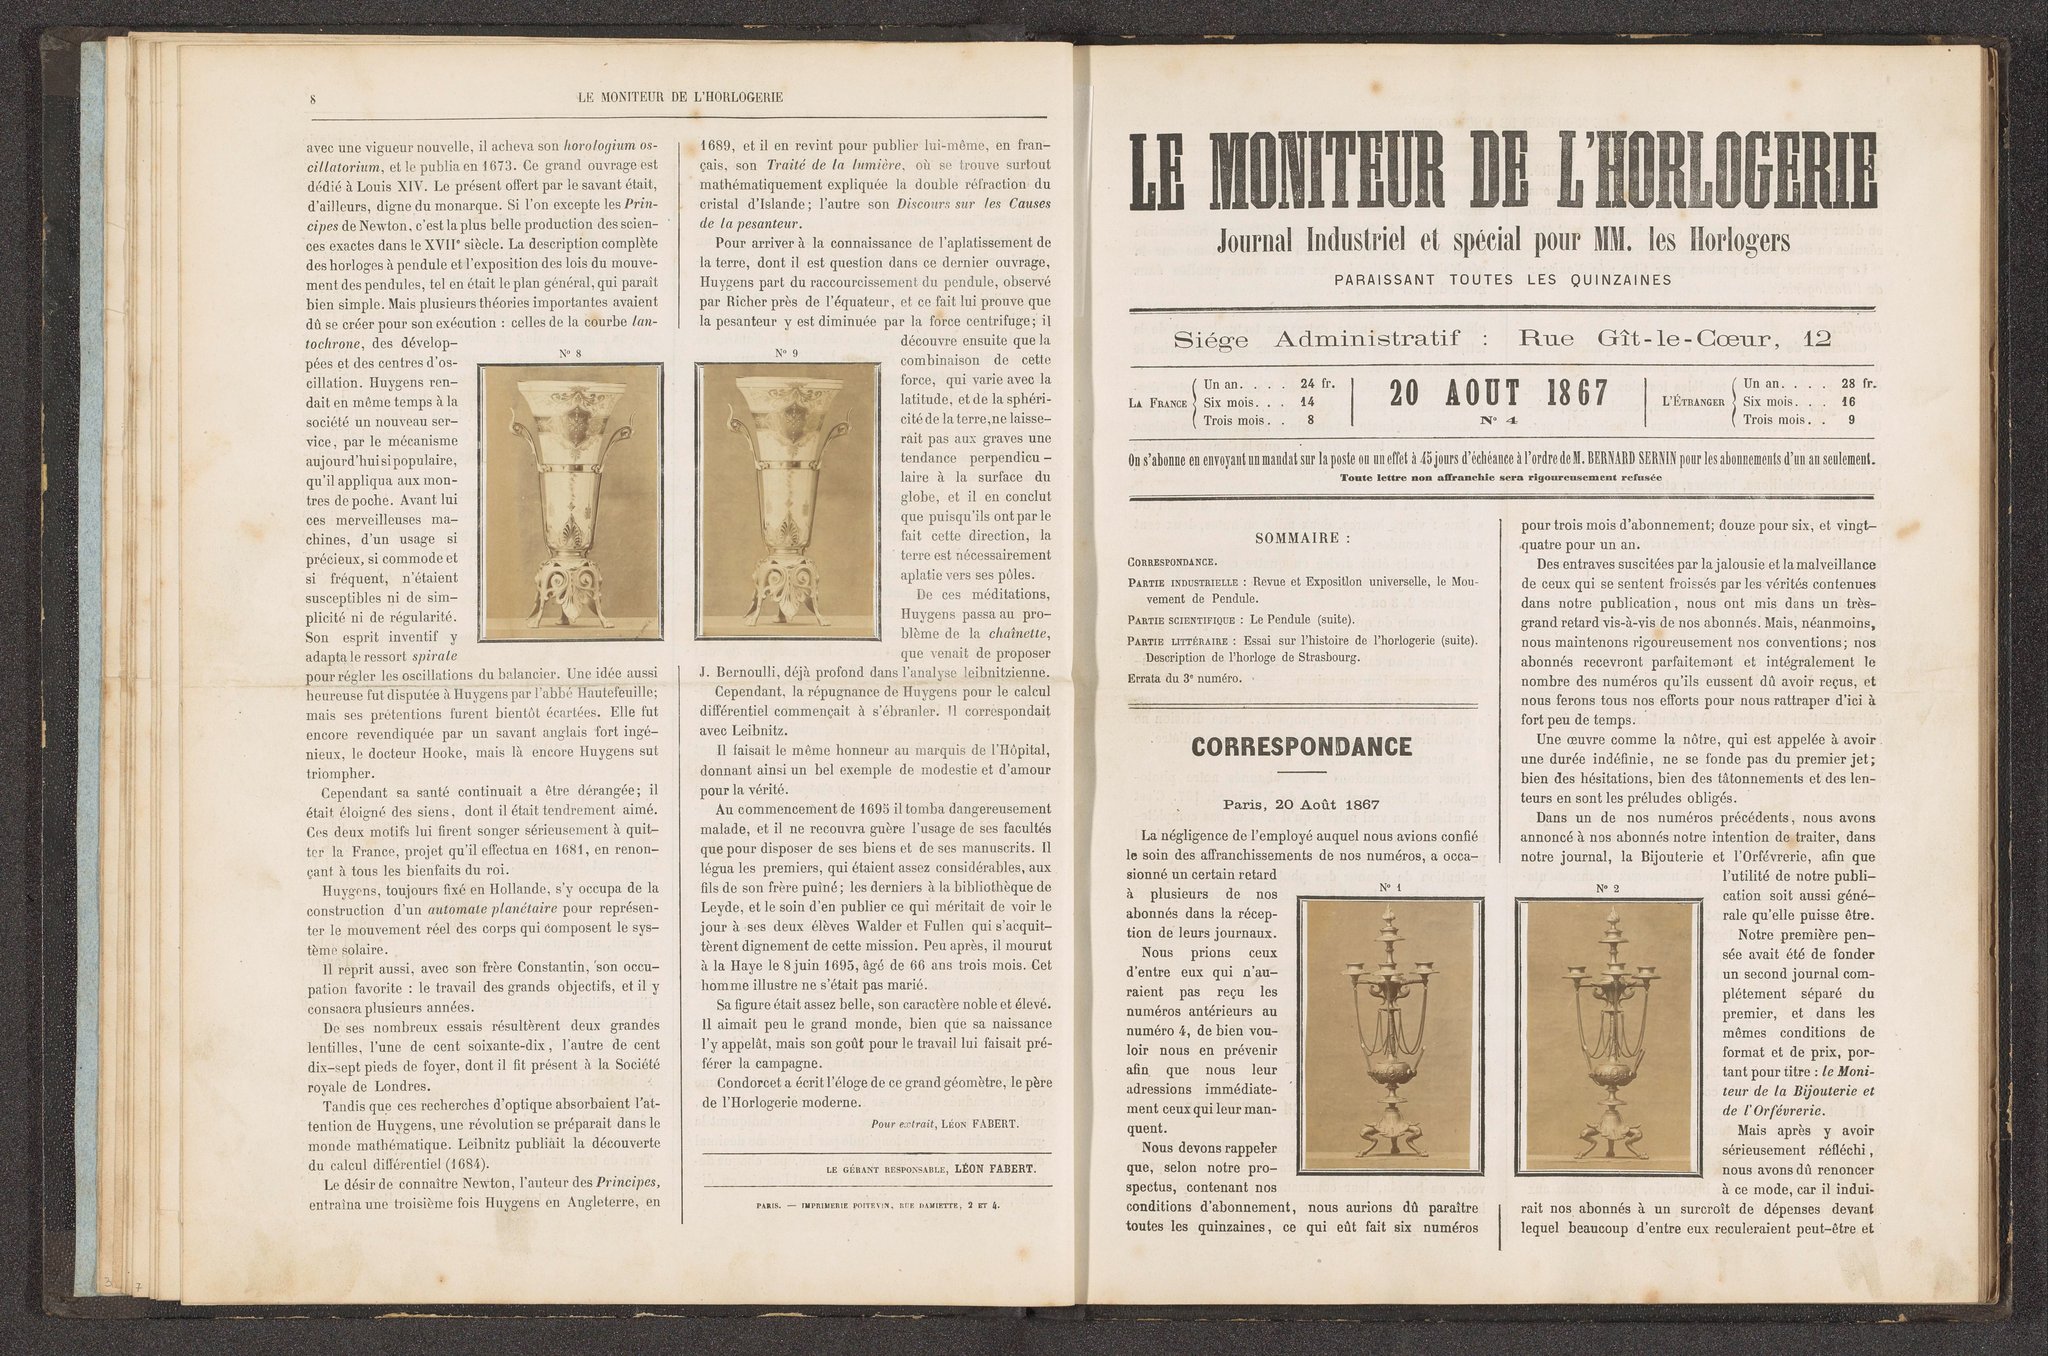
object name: page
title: Twee kandelaren gedecoreerd met een vlam en dierenpoten door M. Dhénain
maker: Anonymous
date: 1857-1867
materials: photographic support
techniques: albumen print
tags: candlestick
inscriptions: number: ‘No 1 No 2’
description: Foto's op pagina 1 van nummer 4 uit 1867.